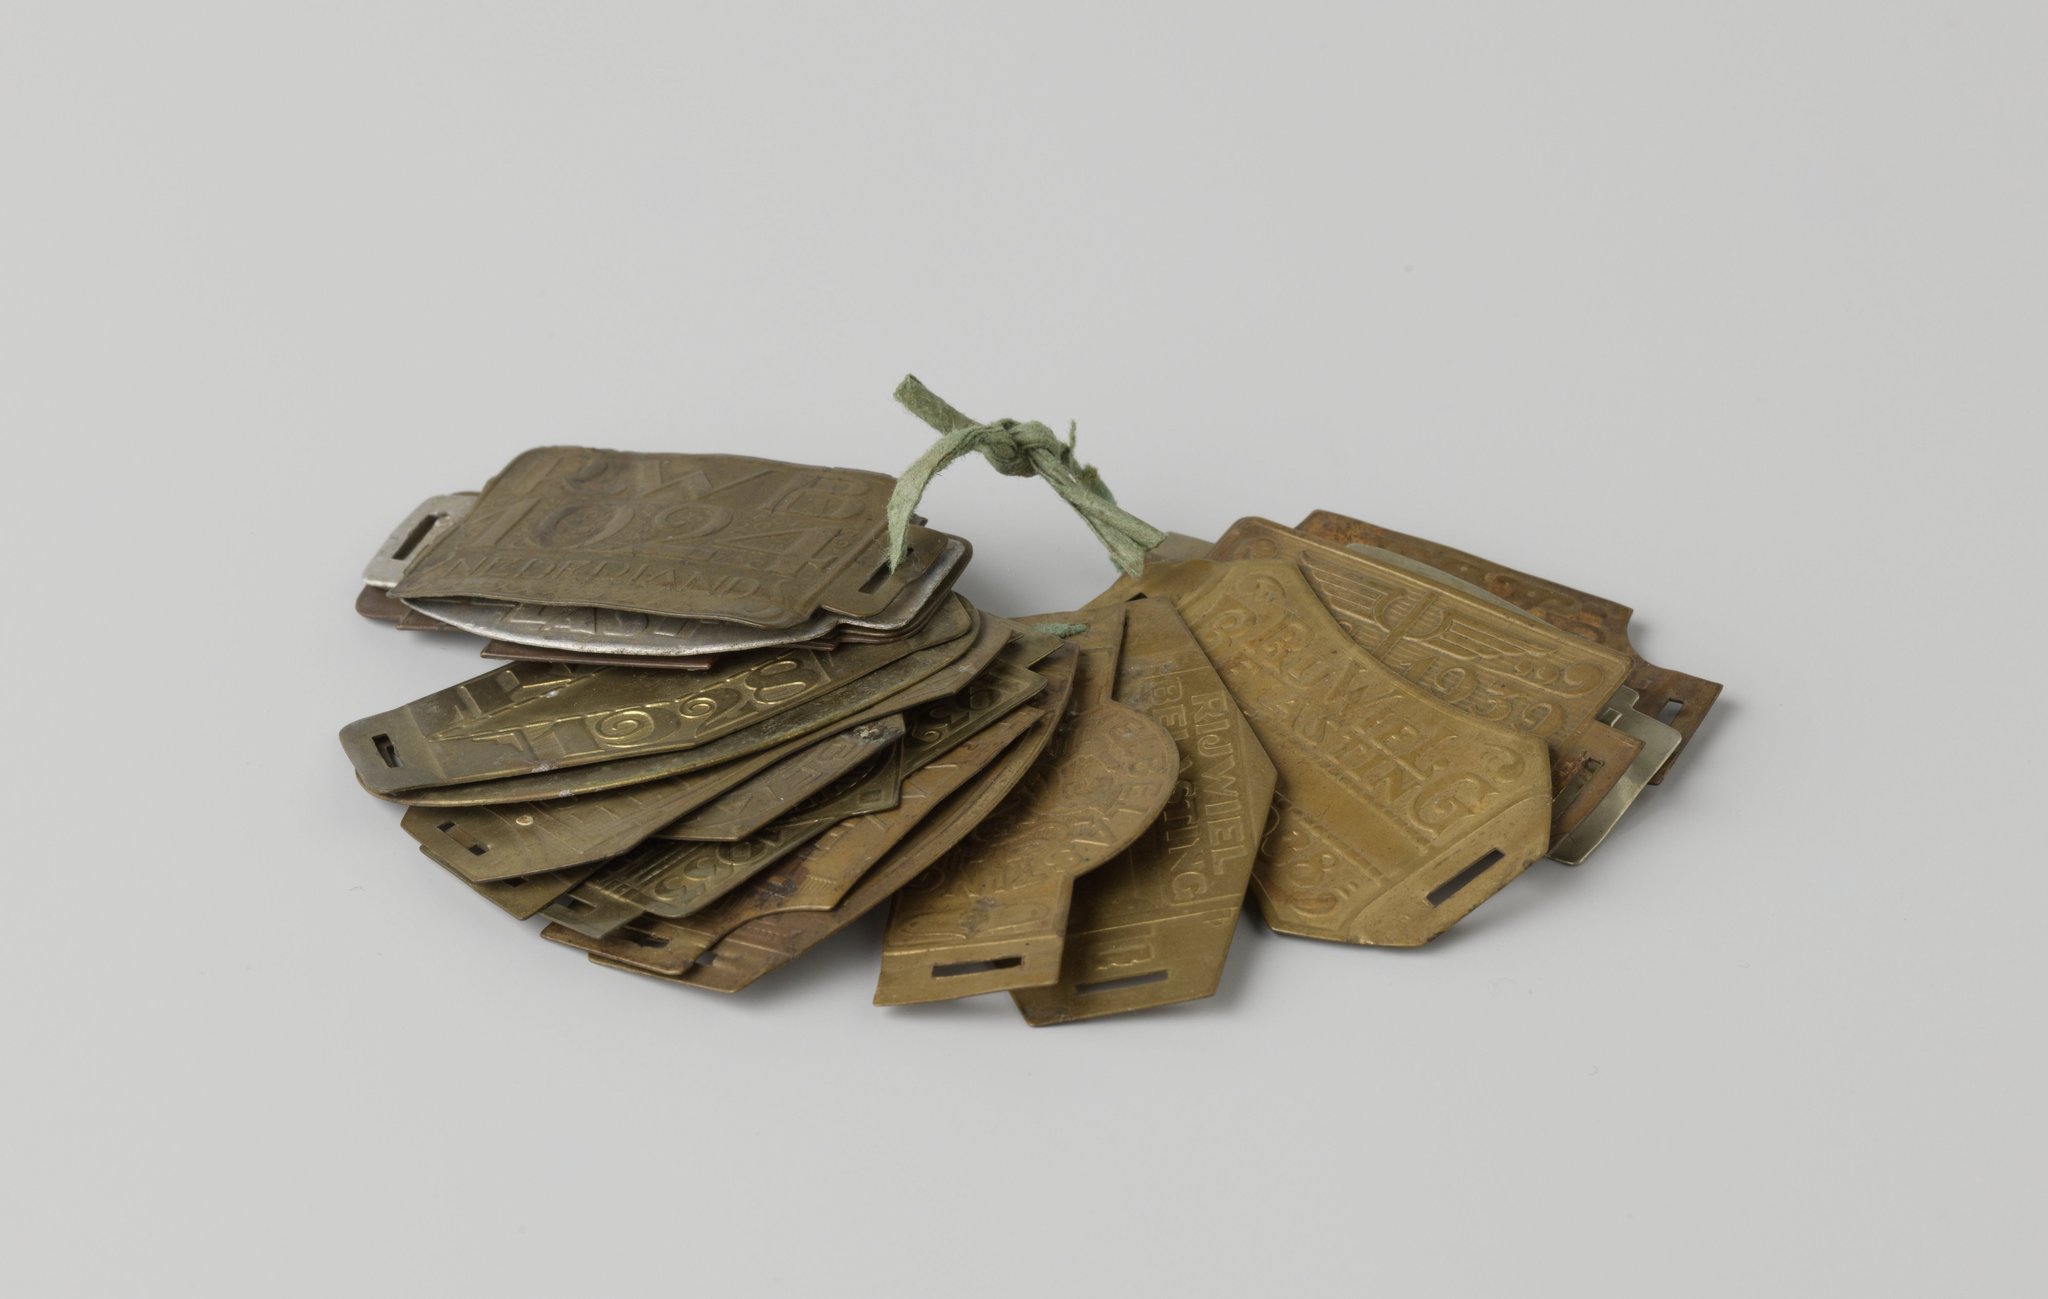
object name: belastingpenning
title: Fietsplaatje, bewijs van betaling van rijwielbelasting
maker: Anonymous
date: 1924-1941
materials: metal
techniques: striking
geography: netherlands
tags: netherlands